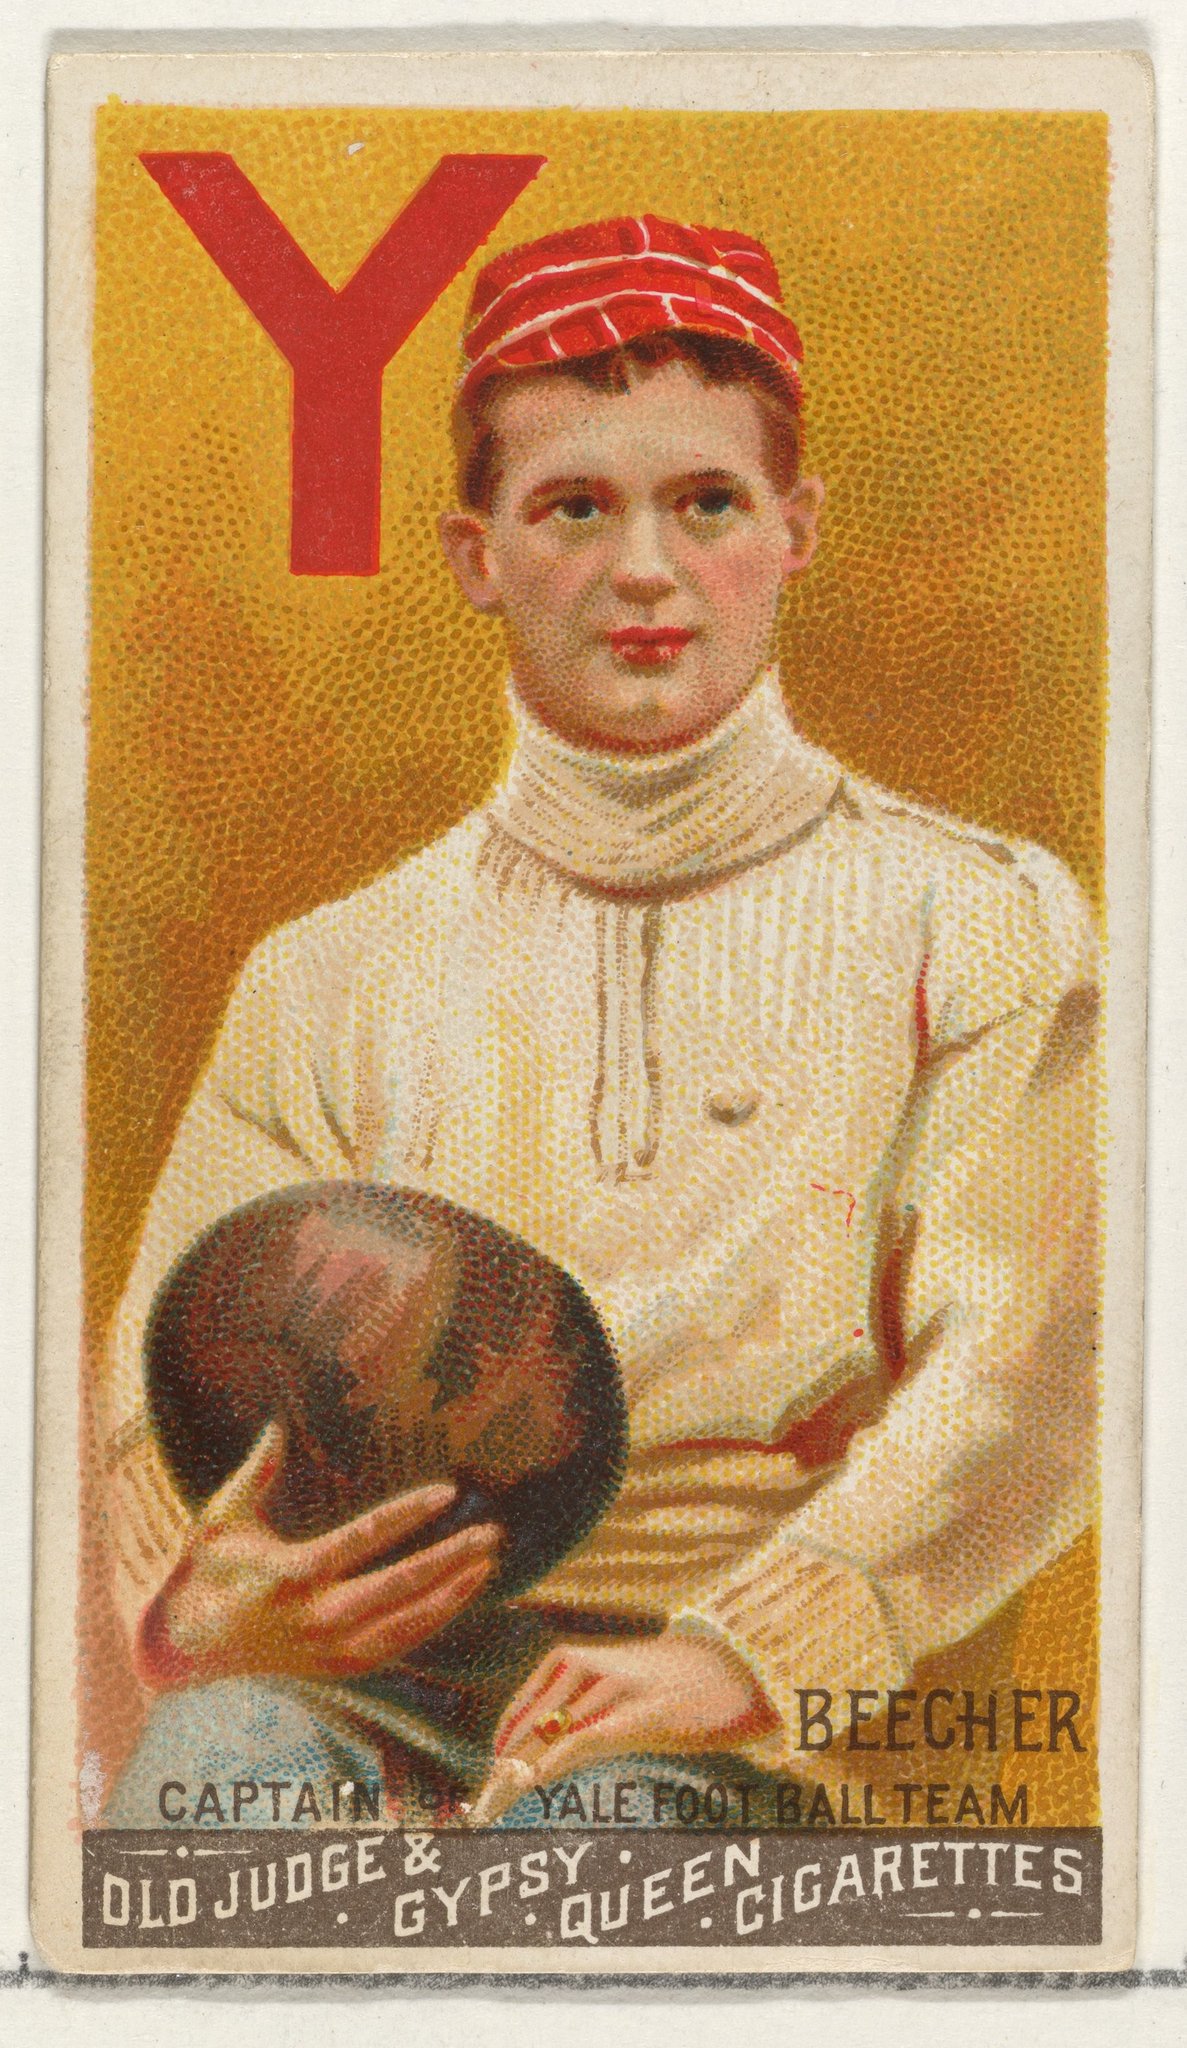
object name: print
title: Edwin Beecher, Captain, Yale University Football Team, from the Goodwin Champion series for Old Judge and Gypsy Queen Cigarettes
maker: goodwin & company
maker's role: publisher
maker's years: 1850-1950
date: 1888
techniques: color lithograph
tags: men,portraits,football,athletes